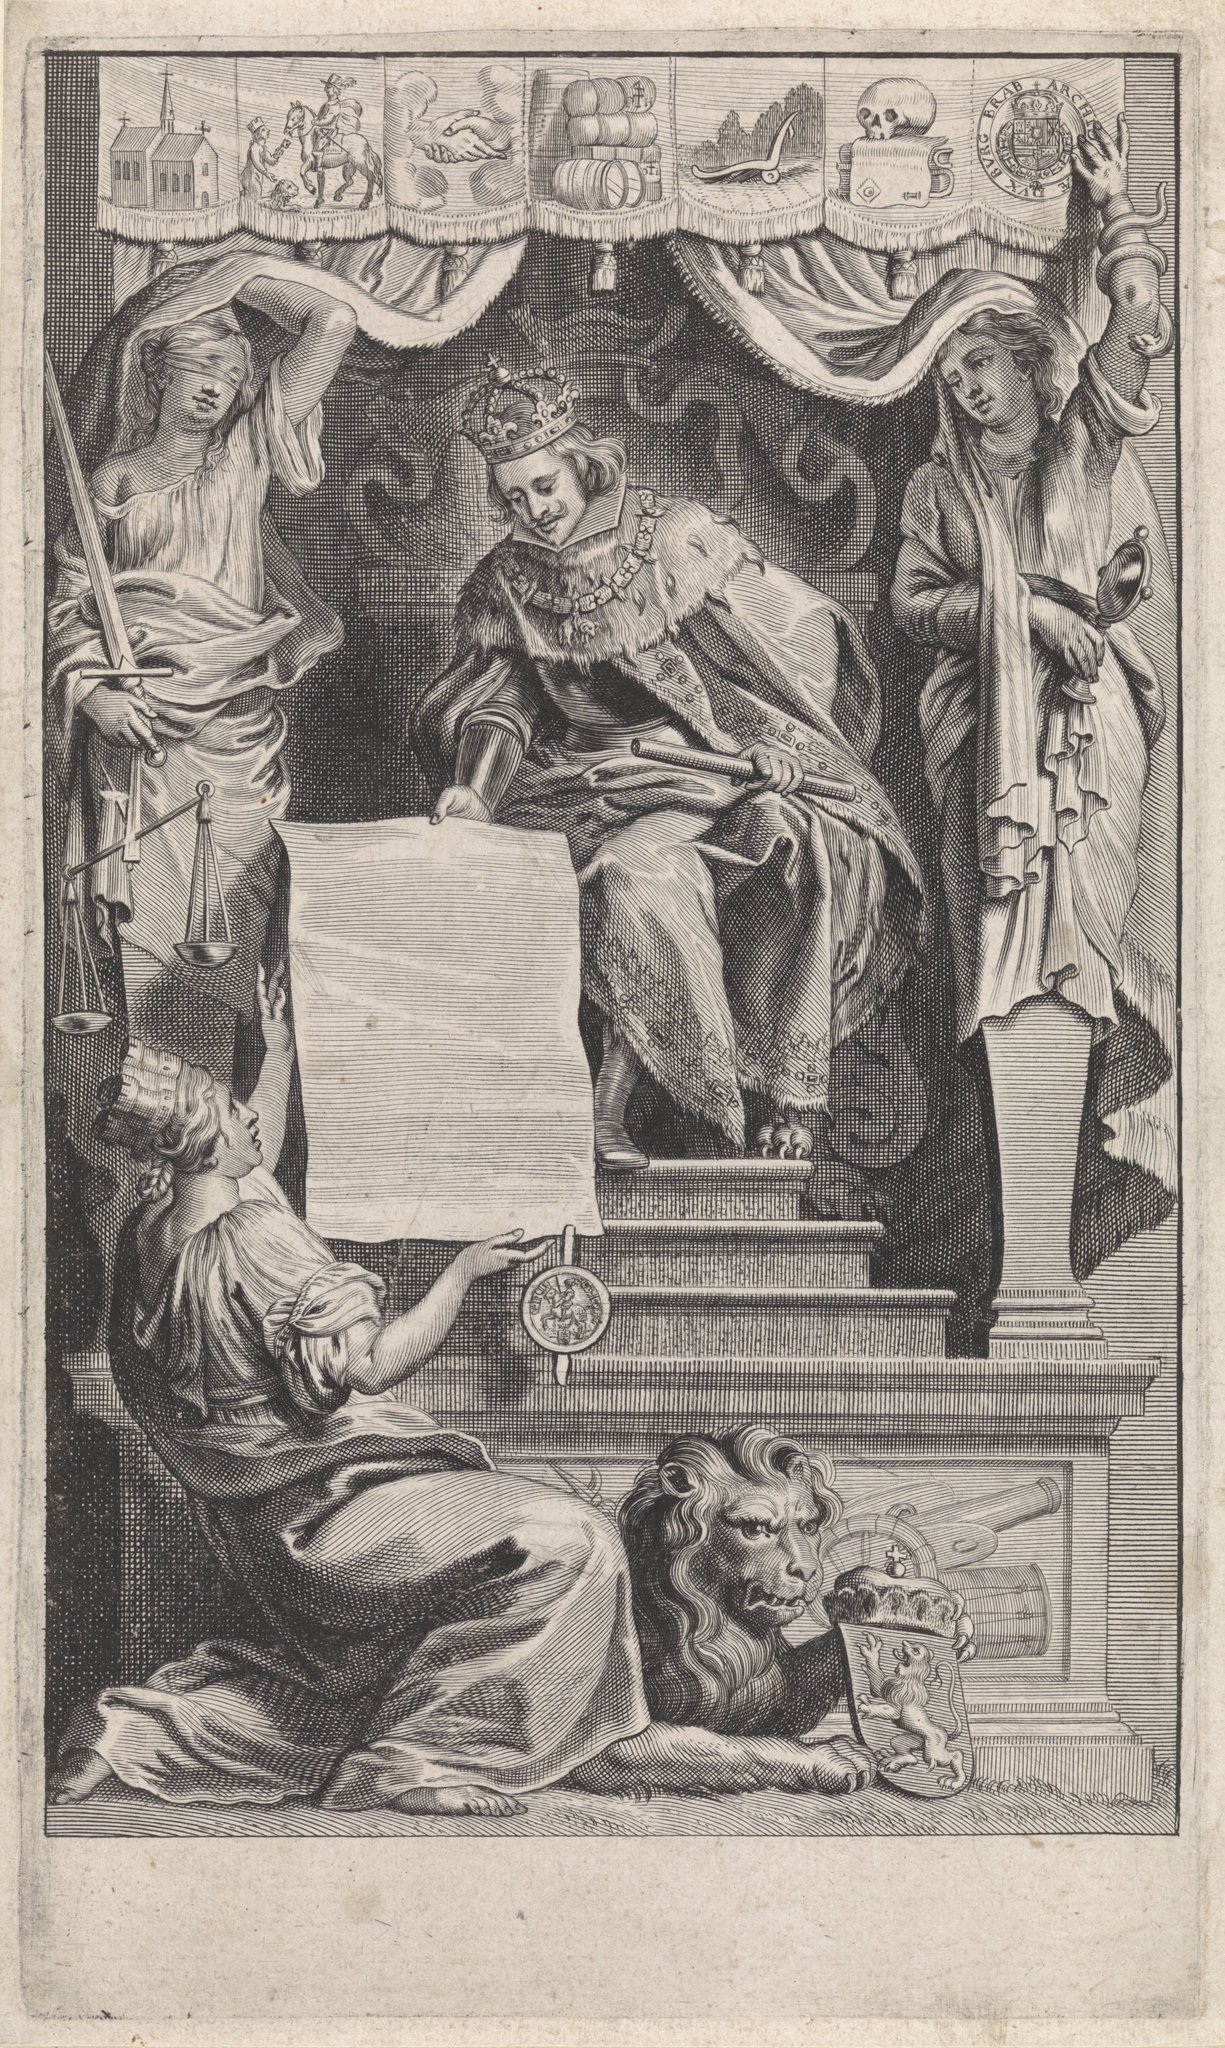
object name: print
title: Titelpagina voor: Placcaeten ordonnantien (...), 1648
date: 1648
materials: paper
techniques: engraving, etching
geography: antwerp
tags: personification of a city, town-patron(ess), justitia (justice) as roman personification, ruler, sovereign, prudentia (prudence) as roman personification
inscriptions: collector's mark: Lugt 240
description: Een hertog op een troon. Op het baldakijn boven de troon staan diverse symbolen. De hertog wordt geflankeerd door een standbeeld van Gerechtigheid (Justitia) en van Voorzichtigheid (Prudentia). Met zijn rechterhand overhandigt hij een papier (zonder titel) aan een vrouwelijke personificatie van een stad. Zij is gekroond met een muurkroon. Een leeuw met het wapenschild van de hertogen van Brabant ligt aan haar voeten.